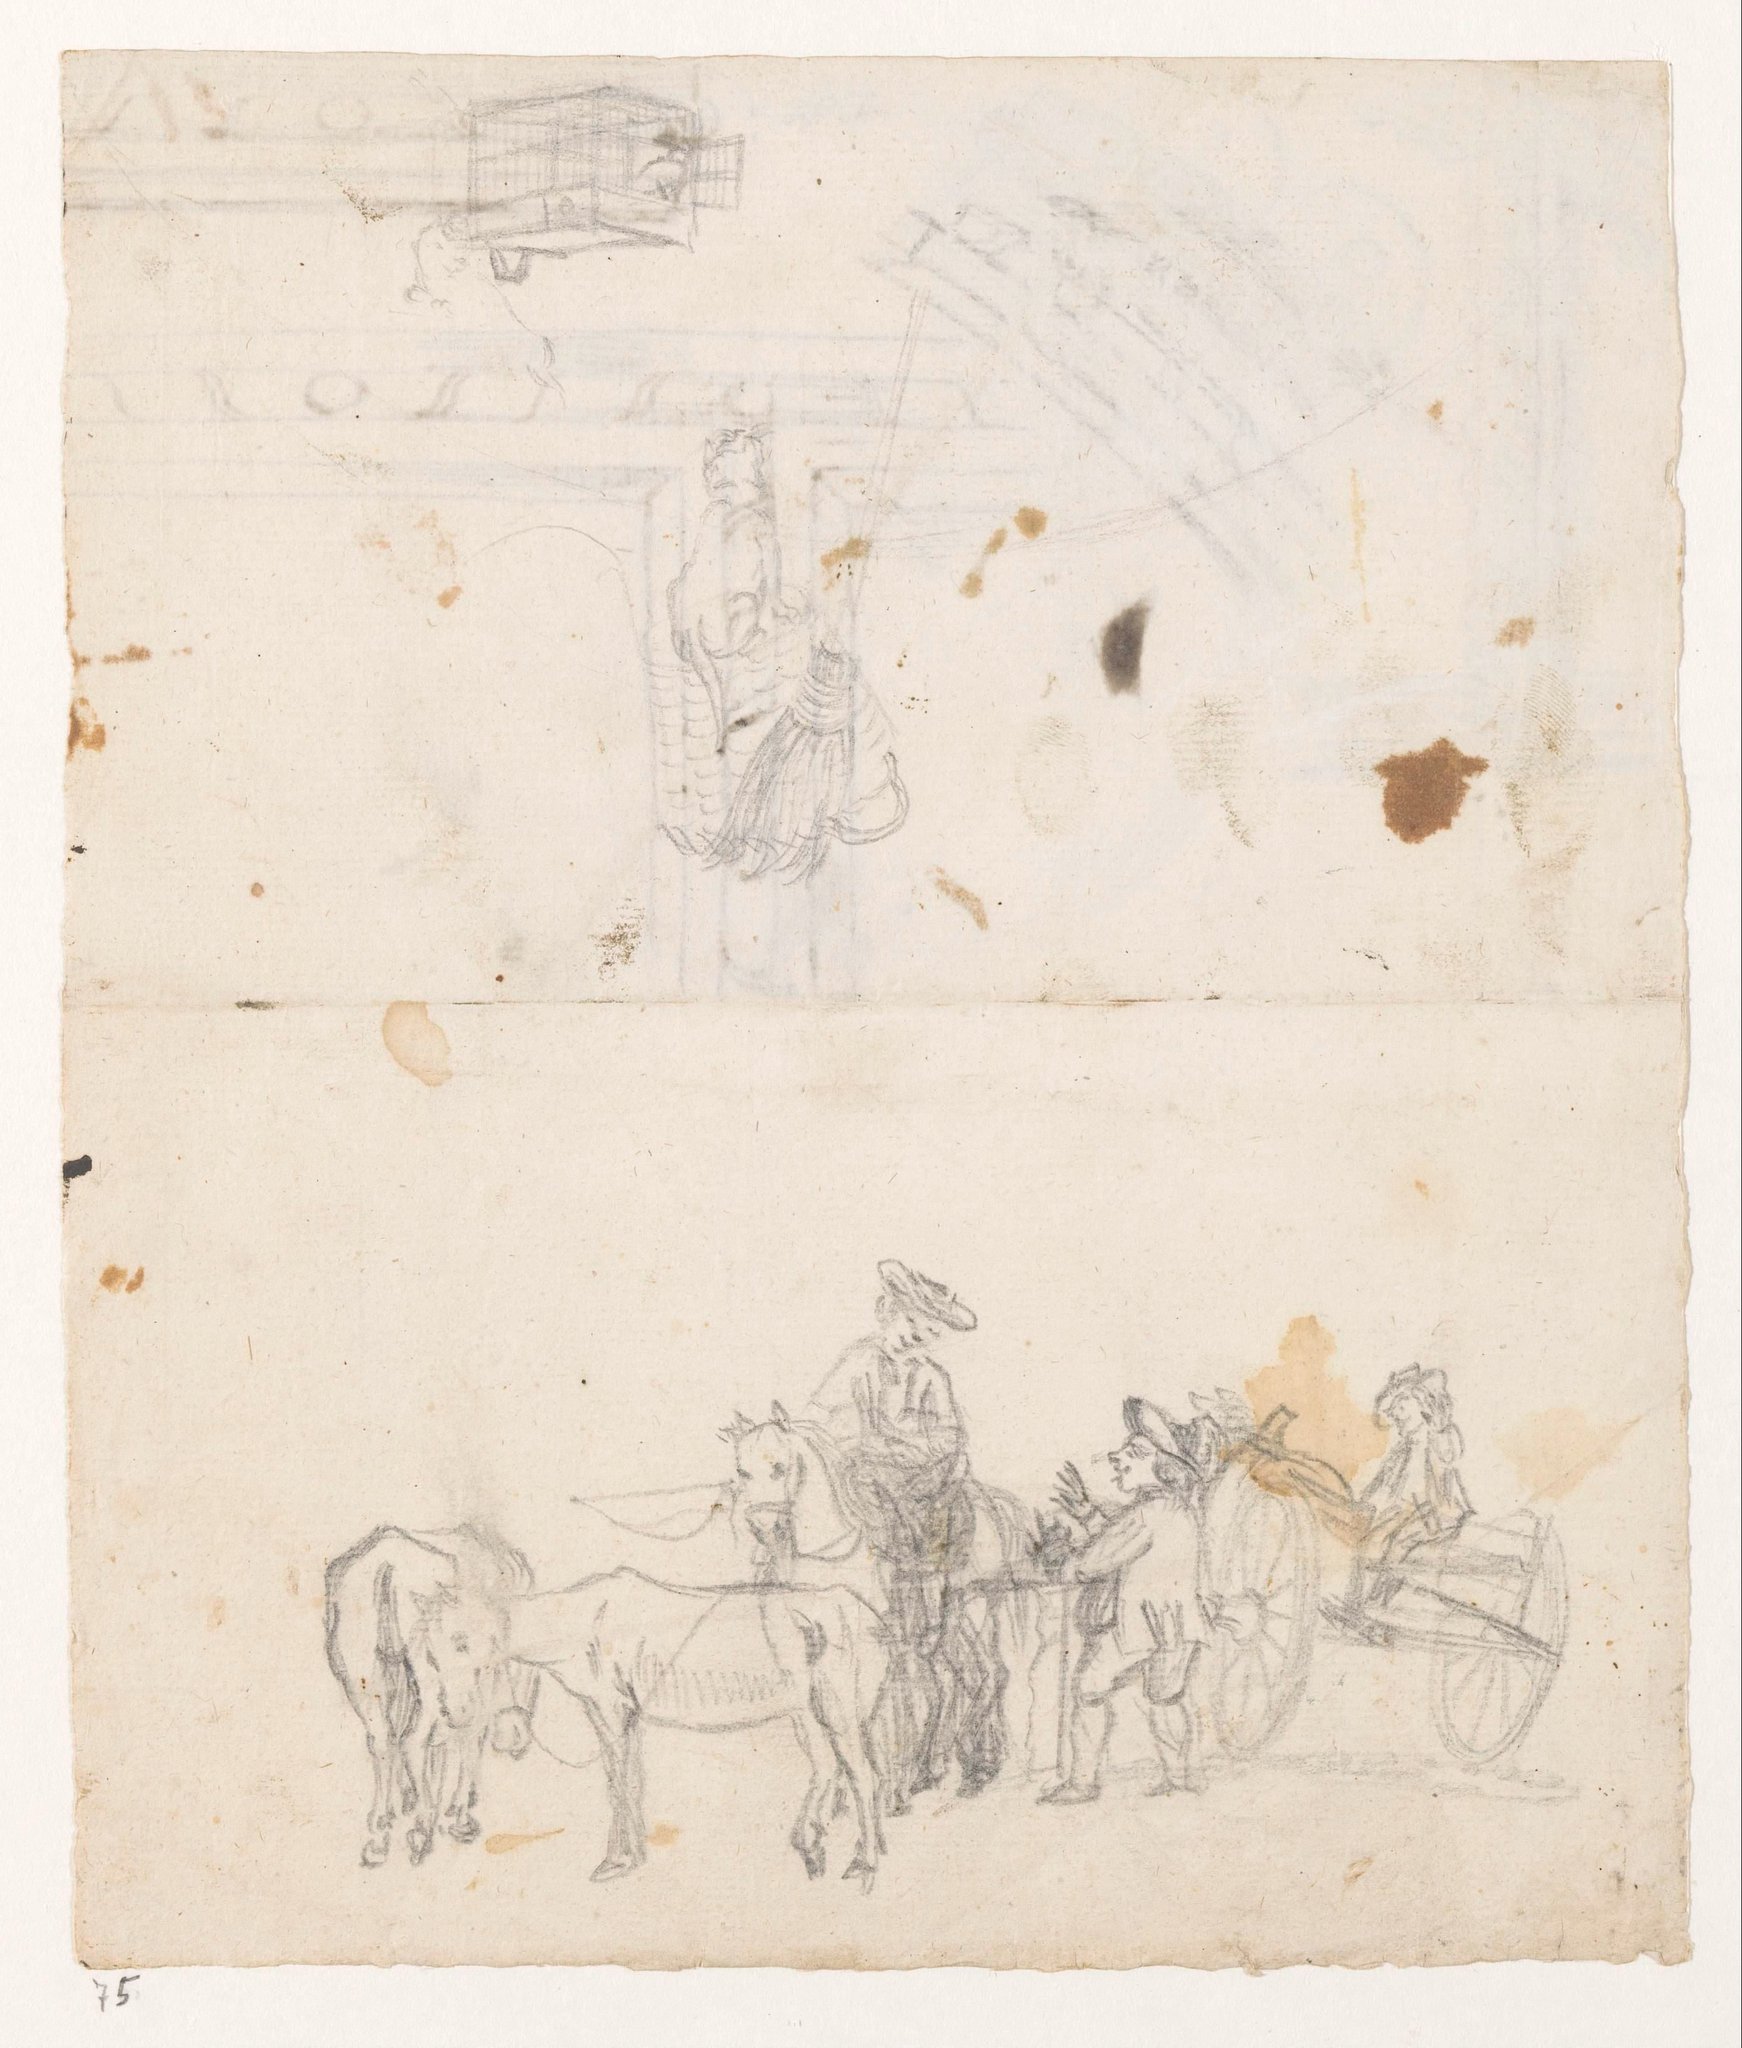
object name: drawing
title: Schetsblad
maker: jan brandes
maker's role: draughtsman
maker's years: 1743-1808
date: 1788-1808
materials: ink, paper, pencil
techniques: pen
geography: skälsebo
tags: riding a horse, ass, or mule; rider, horseman, bird in a cage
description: Blad met schetsen van kat die naar een vogelkooi klimt en van een man pratend met een dame te paard bij een kar met een dame. Op het verso plafondlijsten.